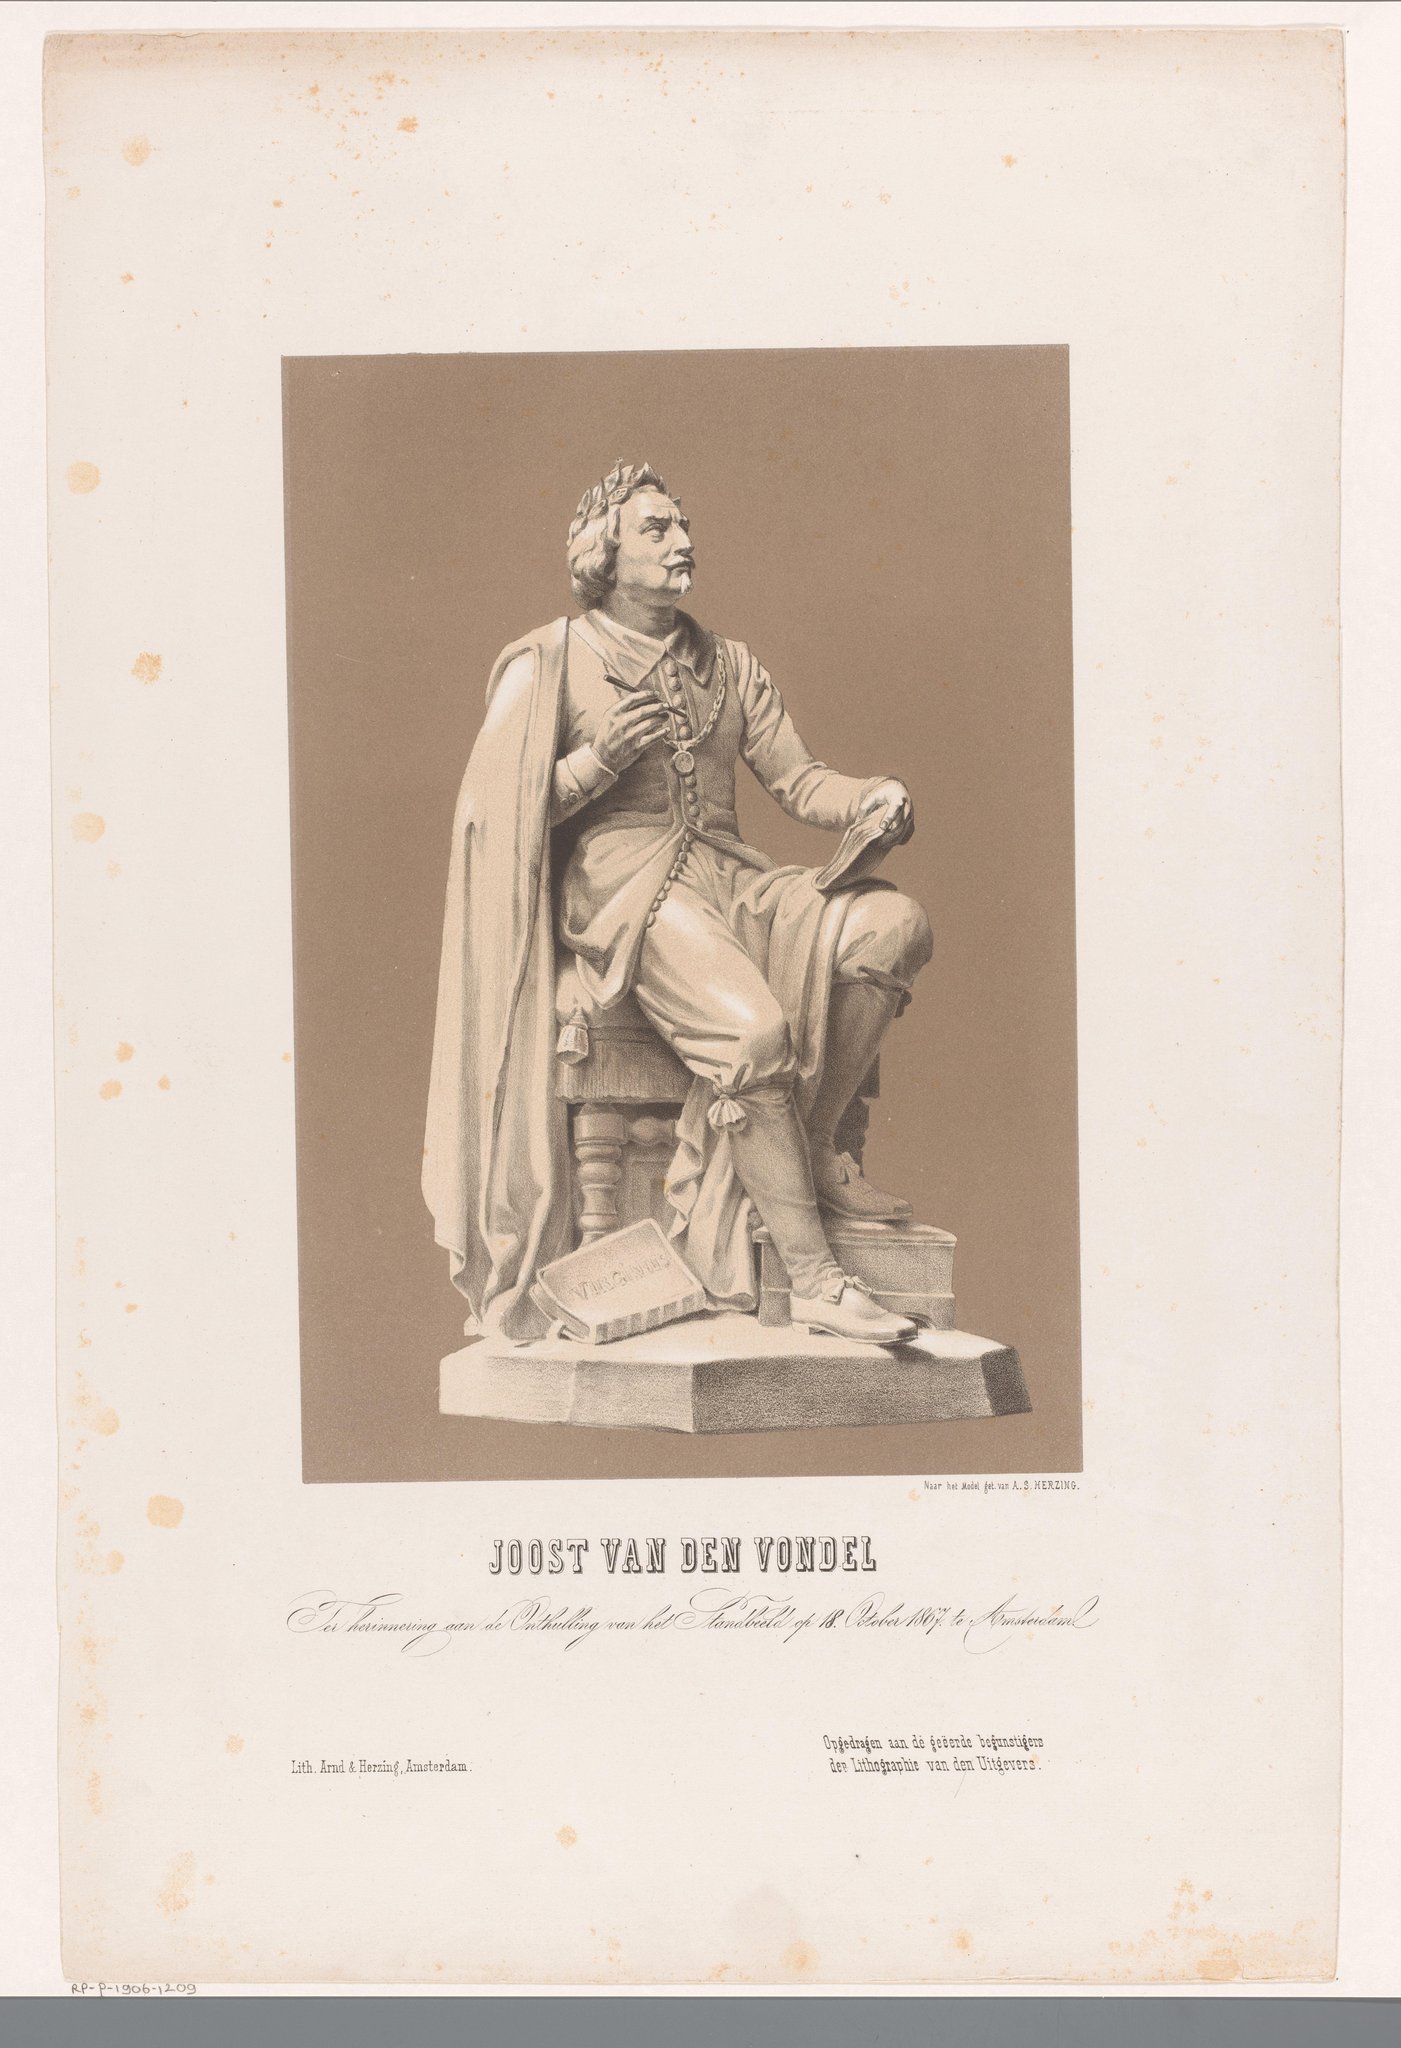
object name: print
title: Standbeeld Joost van den Vondel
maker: andreas sebastian herzing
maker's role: print maker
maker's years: 1845-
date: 1867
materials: paper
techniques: tone lithography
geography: amsterdam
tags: cologne, amsterdam, joost van den vondel, monument, statue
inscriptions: collector's mark: Lugt 2228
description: De schrijver zit op een stoel. Hij heeft een pen in zijn rechterhand en een boek in zijn linkerhand. Hij draagt een lauwerkrans op het hoofd.